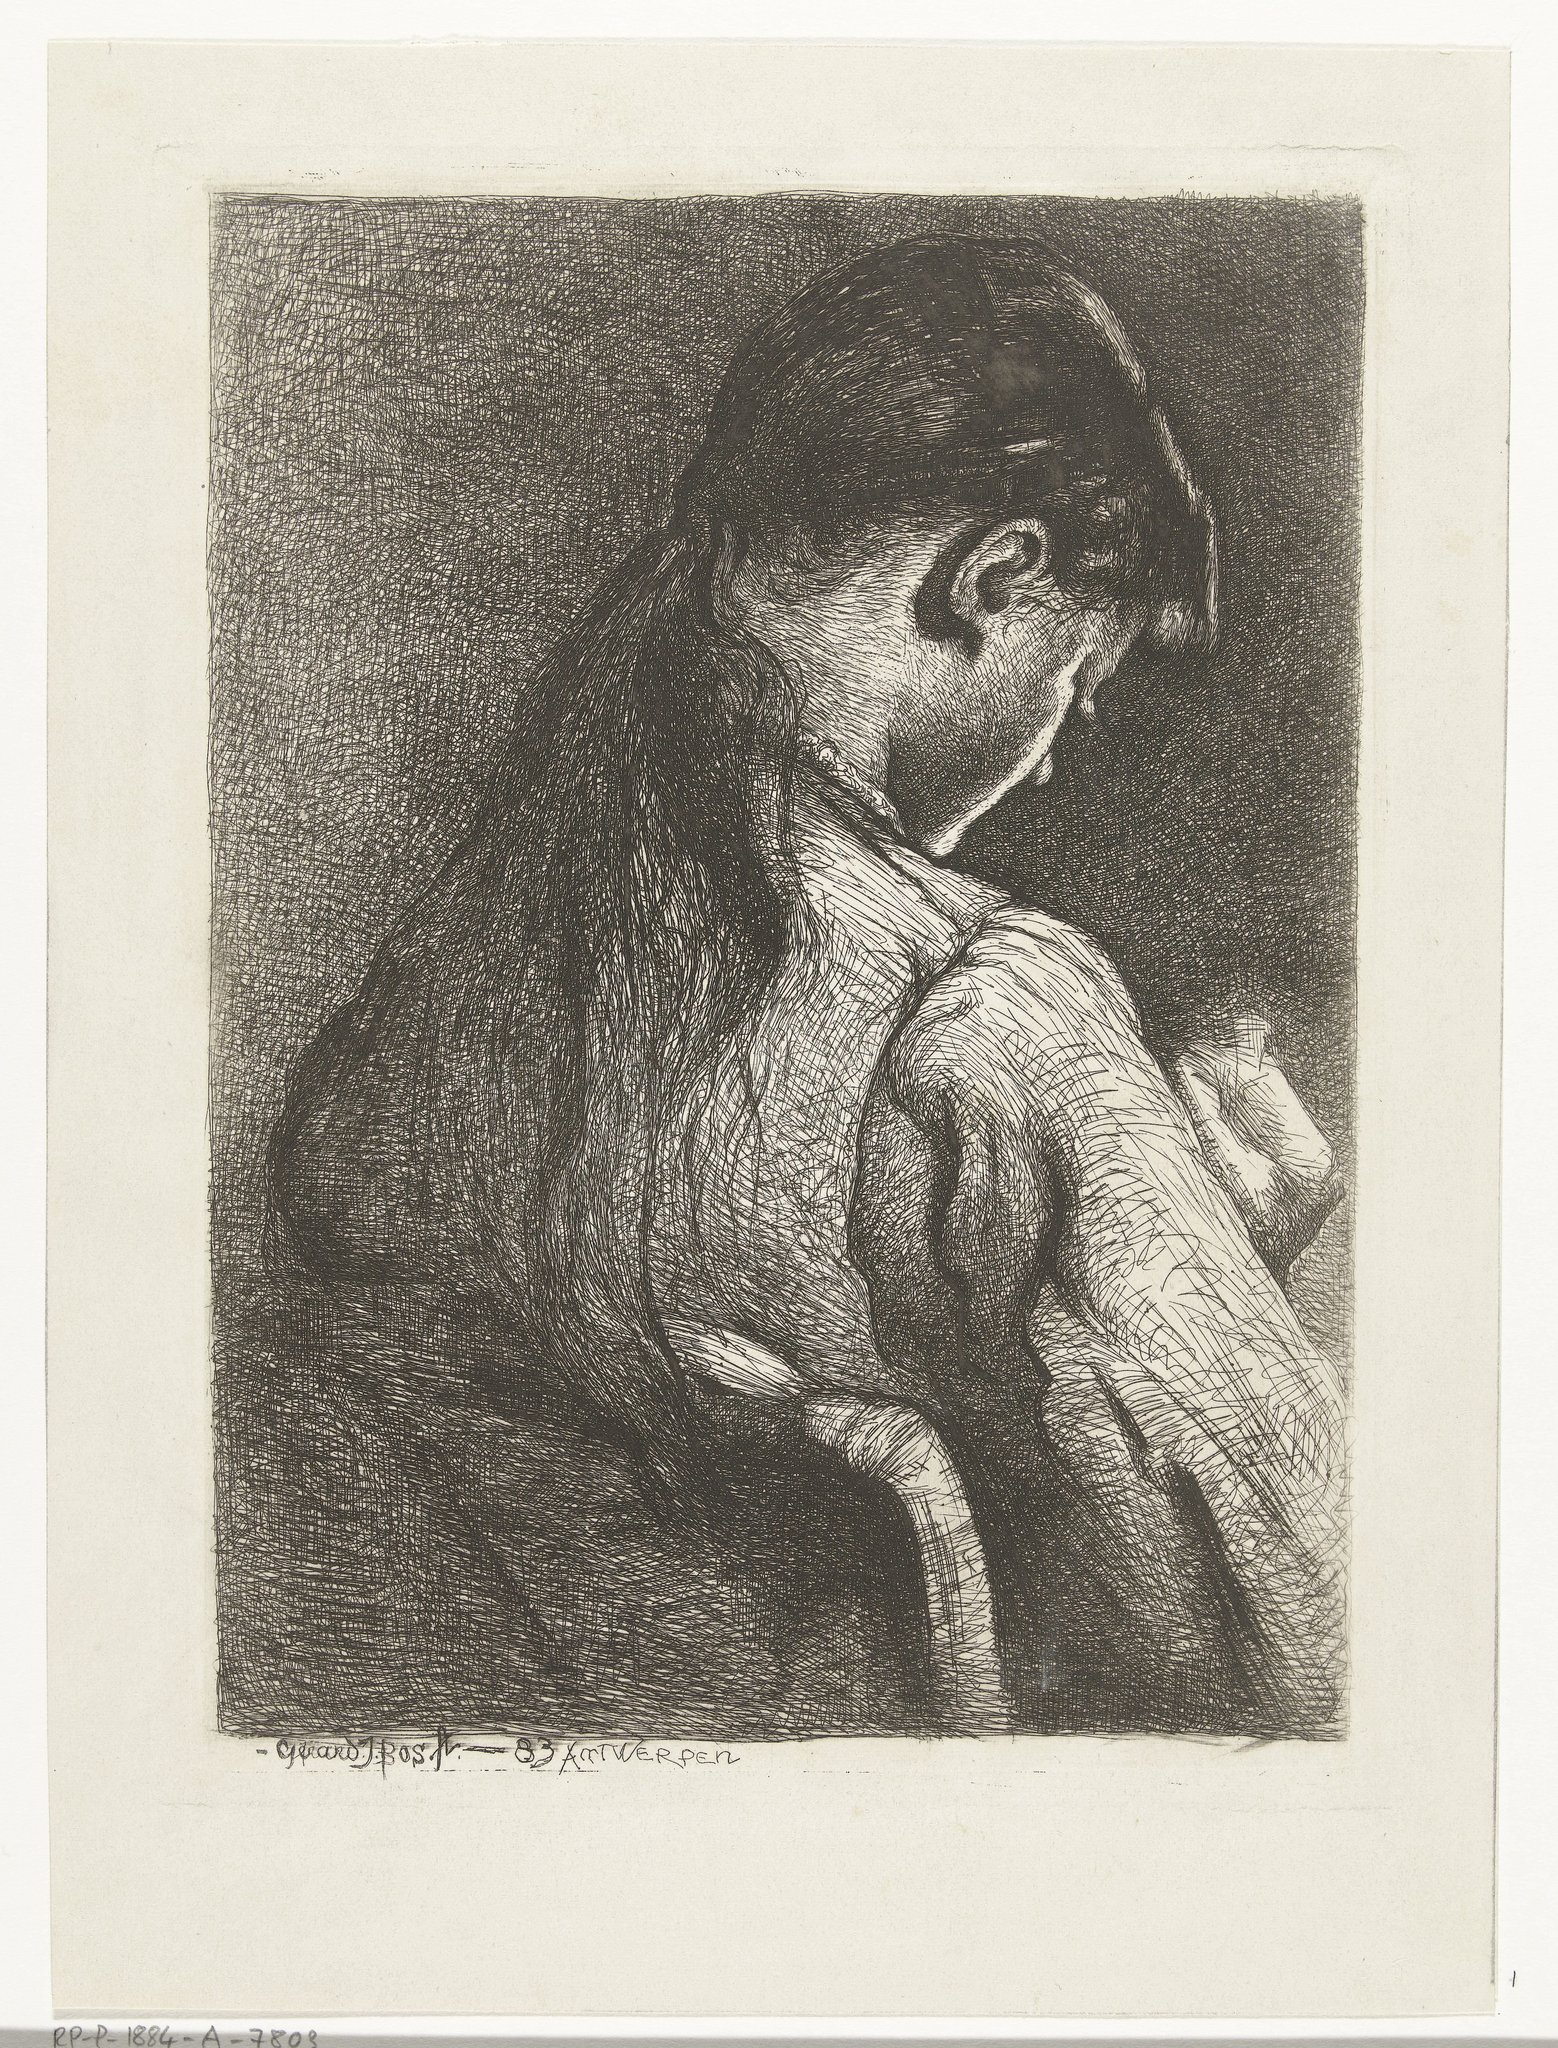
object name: print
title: Zittend meisje, op haar rug gezien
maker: gerard jan bos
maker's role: print maker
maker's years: 1860-1943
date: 1883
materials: paper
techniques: etching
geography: antwerp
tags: girl (child between toddler and youth) (+ back view with lost profile)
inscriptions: collector's mark: Lugt 2228